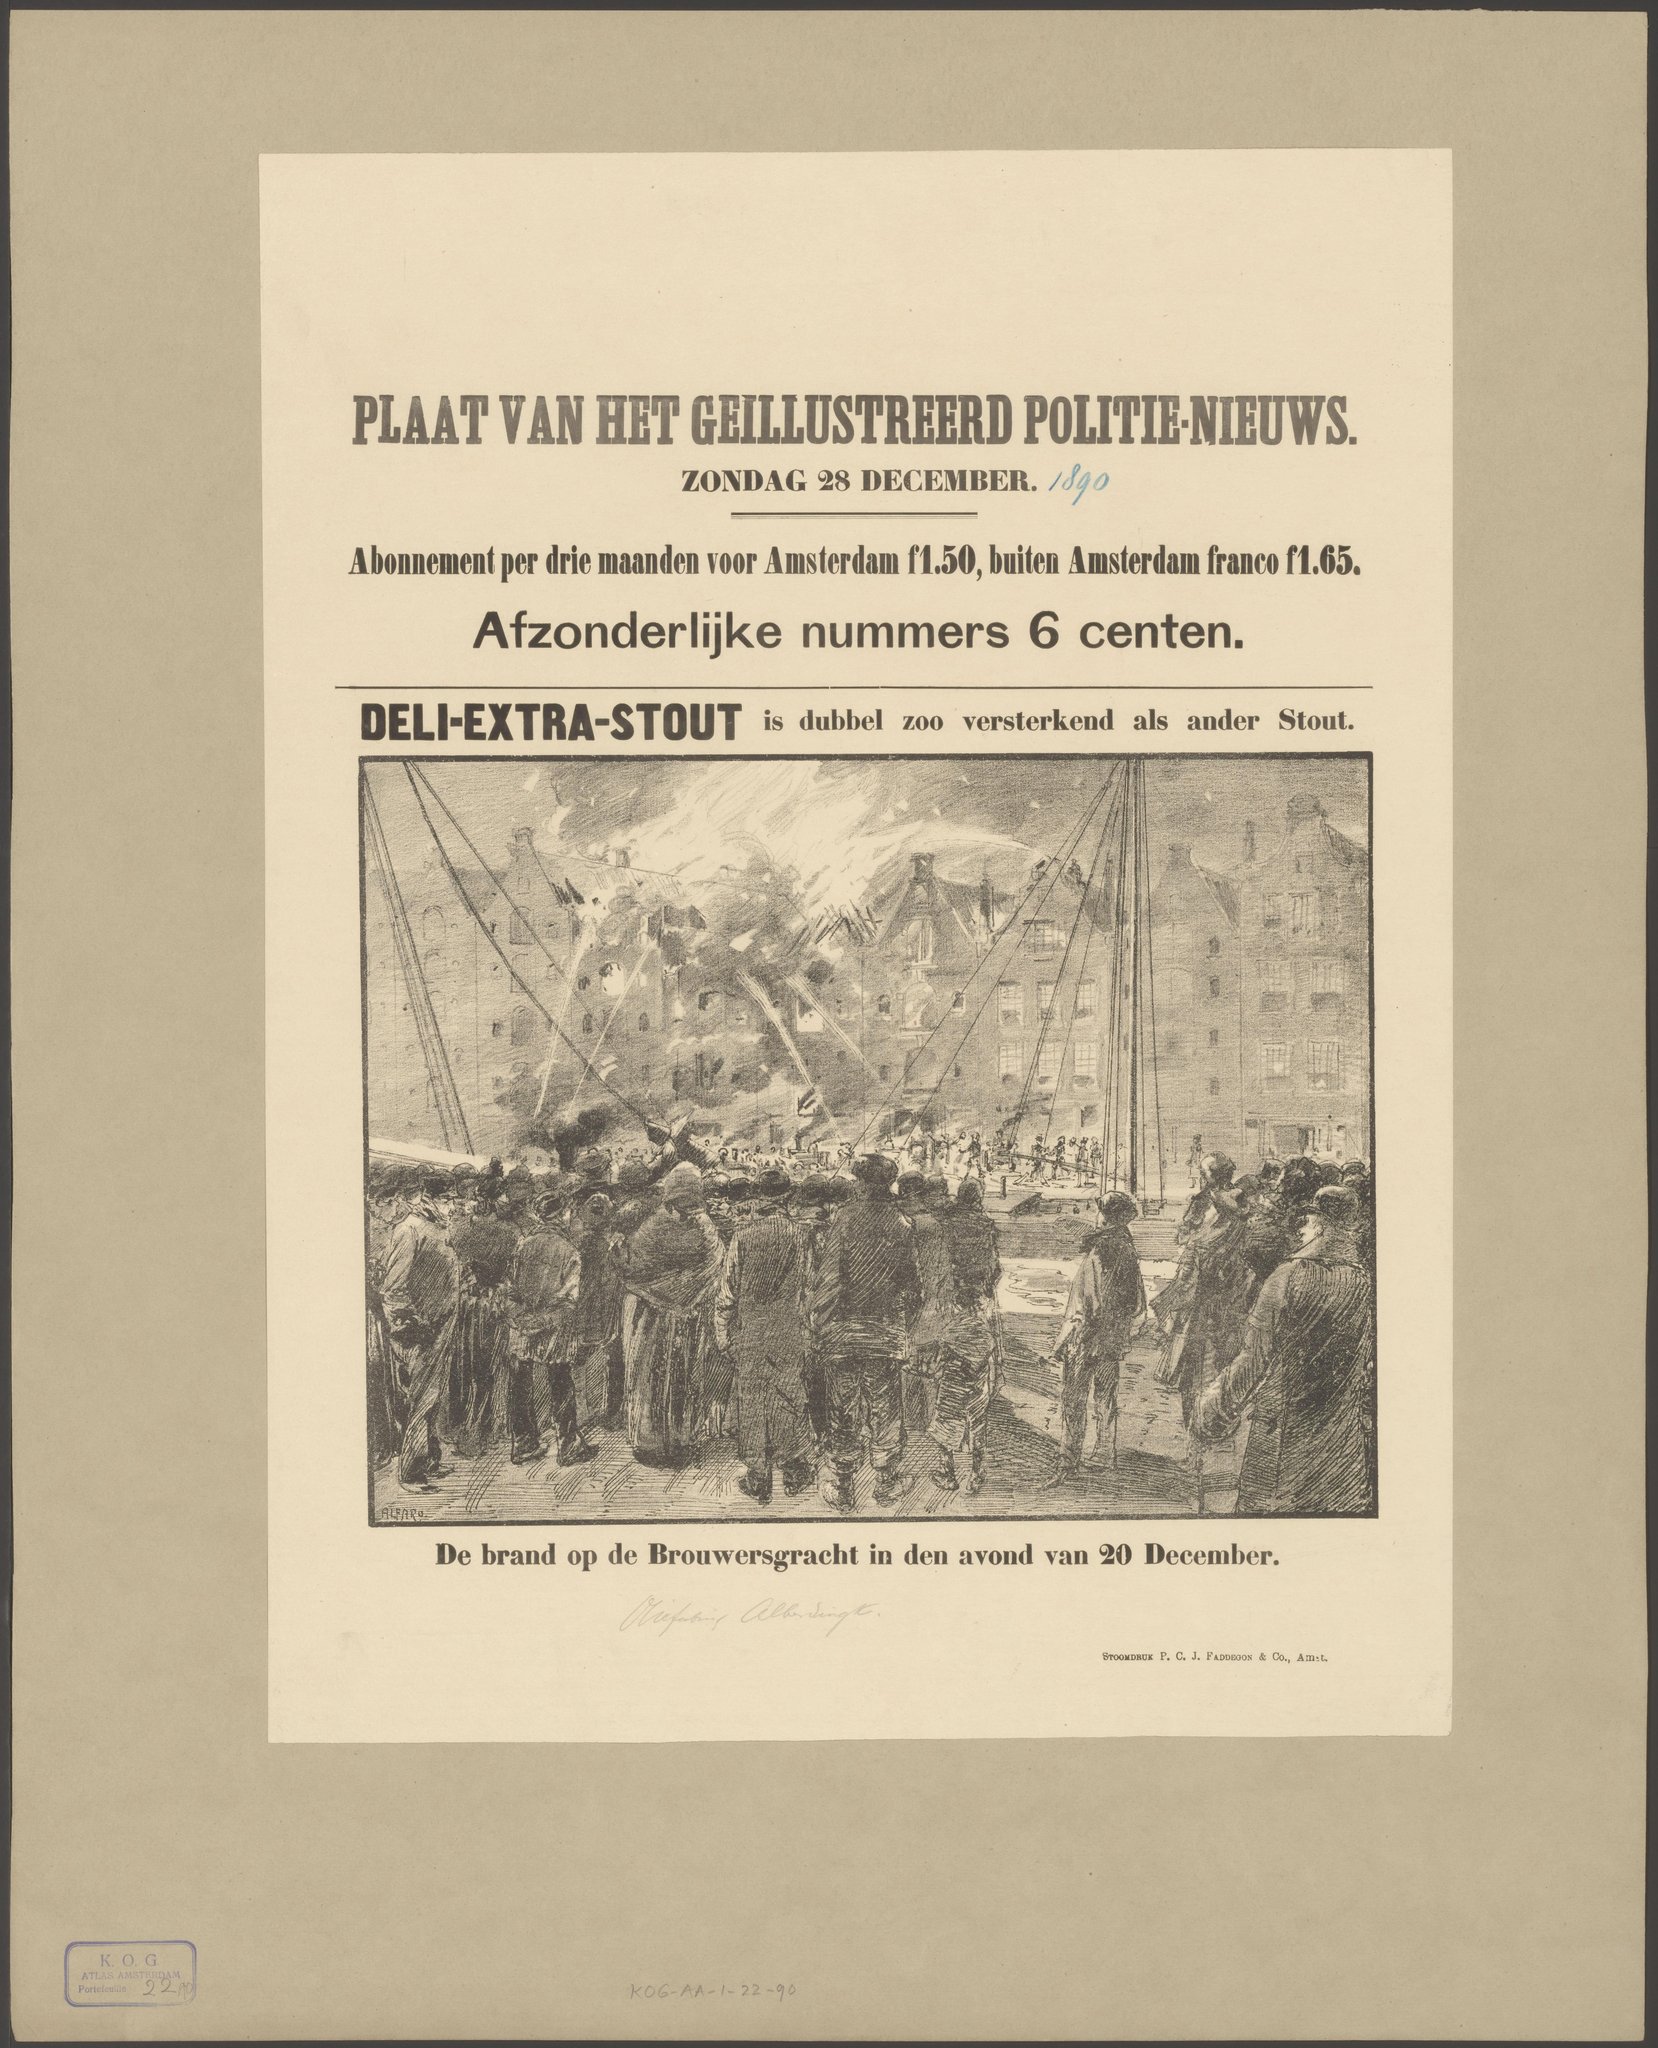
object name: print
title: De brand op de Brouwersgracht in den avond van 20 December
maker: alfaro reijding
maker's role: draughtsman, engineer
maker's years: 1863-1930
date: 1890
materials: paper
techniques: letterpress printing, lithograph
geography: amsterdam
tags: on fire, ablaze, fire-fighting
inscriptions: collector's mark: Lugt 1641b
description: Onderwerpsrubriek binnen de Atlas Amsterdam: Gemeentewerken: B. Branden in particuliere gebouwen.